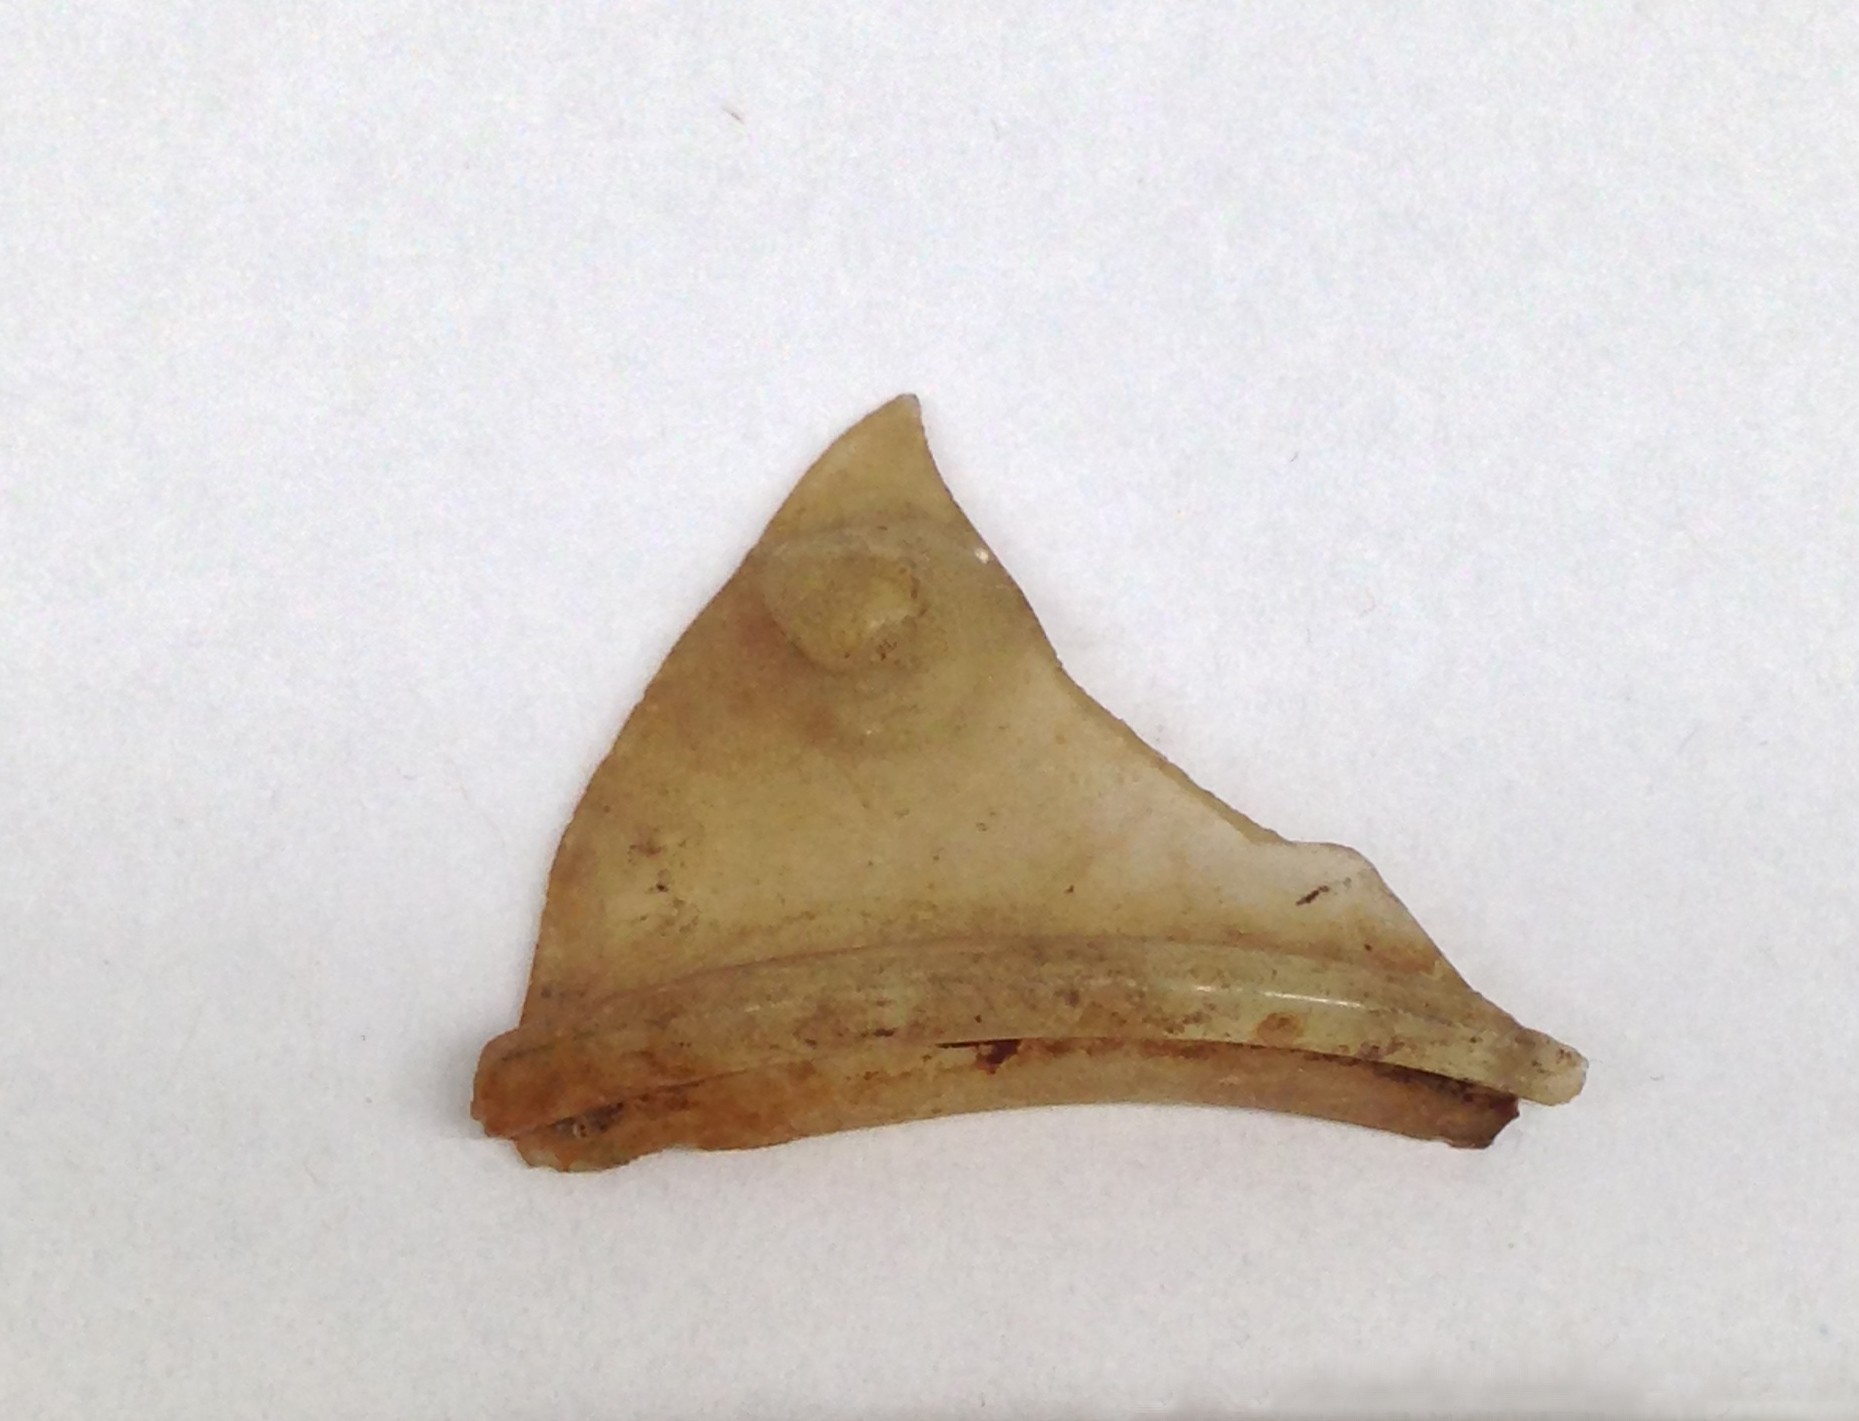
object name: glass fragment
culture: crusader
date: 1201-1300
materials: glass